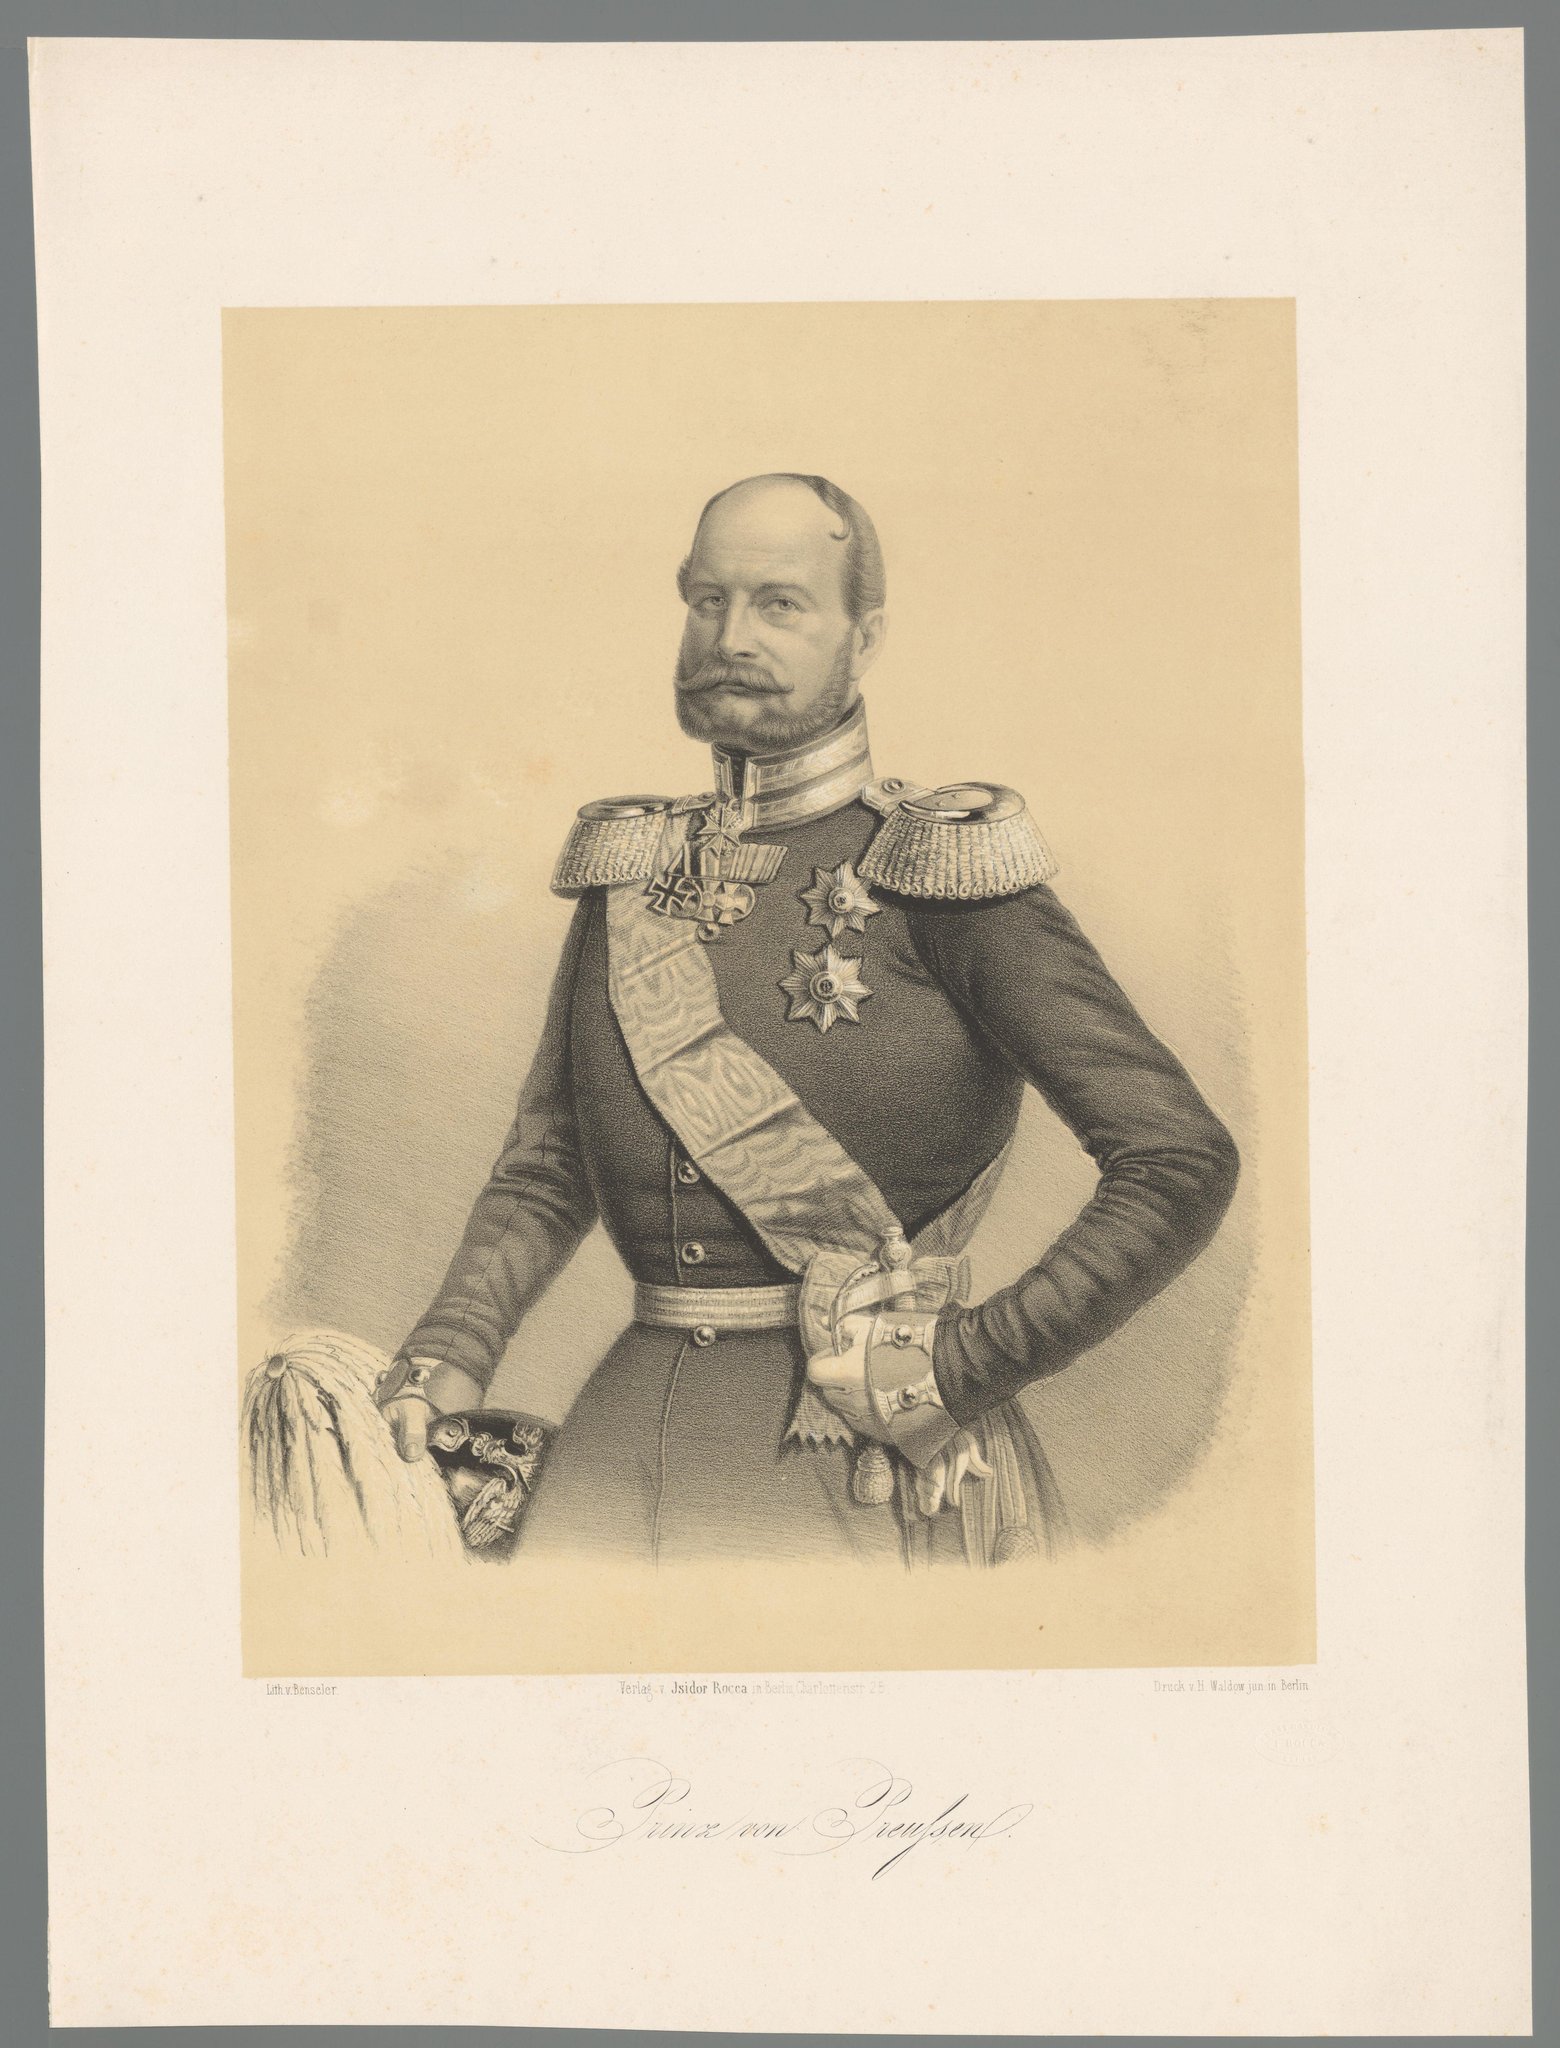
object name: print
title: Prinz von Preussen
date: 1850-1899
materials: paper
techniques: tone lithography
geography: berlin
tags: berlin, wilhelm i (keizer van duitsland), adult man, historical persons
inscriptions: collector's mark: Lugt 2228, check stamp: ‘Kunsthandlung I. Rocca Berlin’